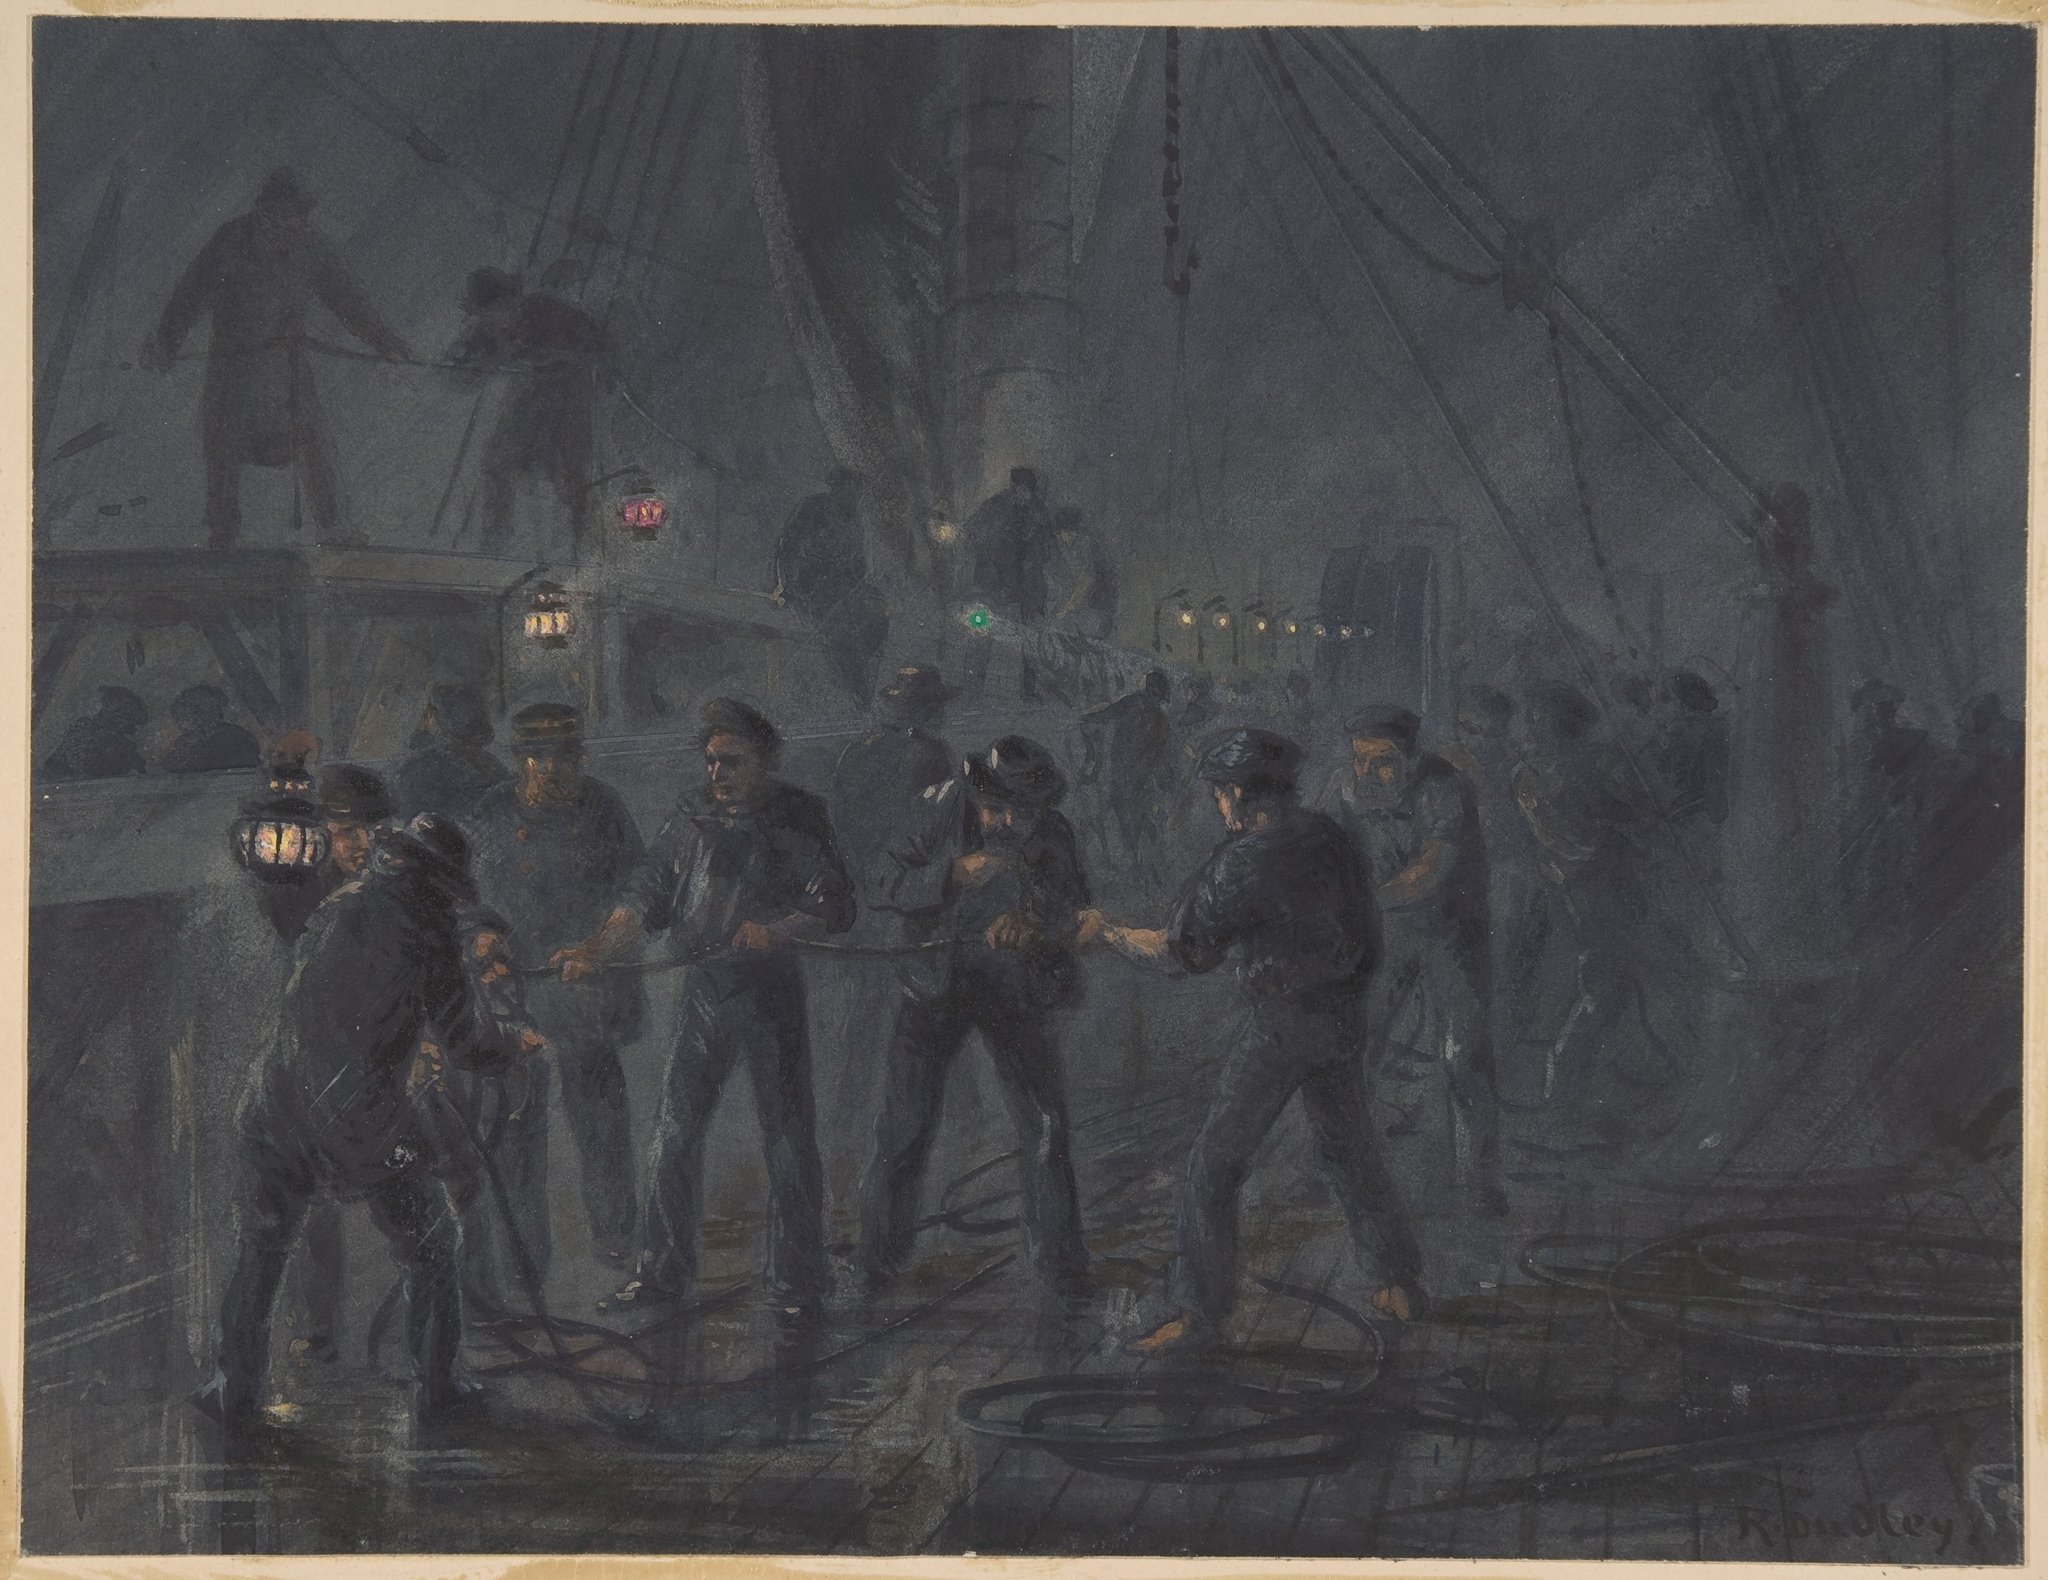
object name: drawing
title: A Night Scene. The Cable Entangled and Nearly Broken, July 18th, 1866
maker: robert charles dudley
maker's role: artist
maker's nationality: british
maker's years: 1826-1909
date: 1865-1866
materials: gouache, graphite, watercolor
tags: men,night,working,ships,transatlantic cable